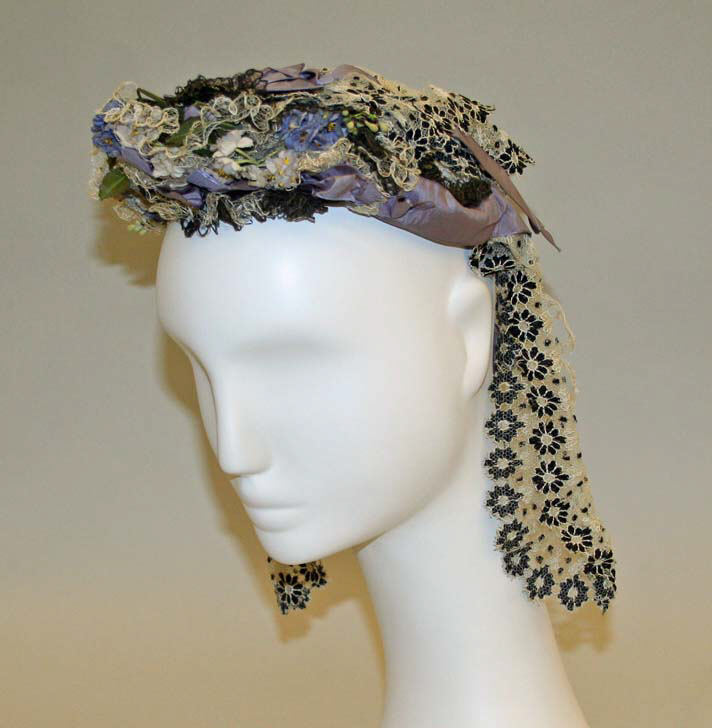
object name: cap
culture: american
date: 1863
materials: cotton, silk